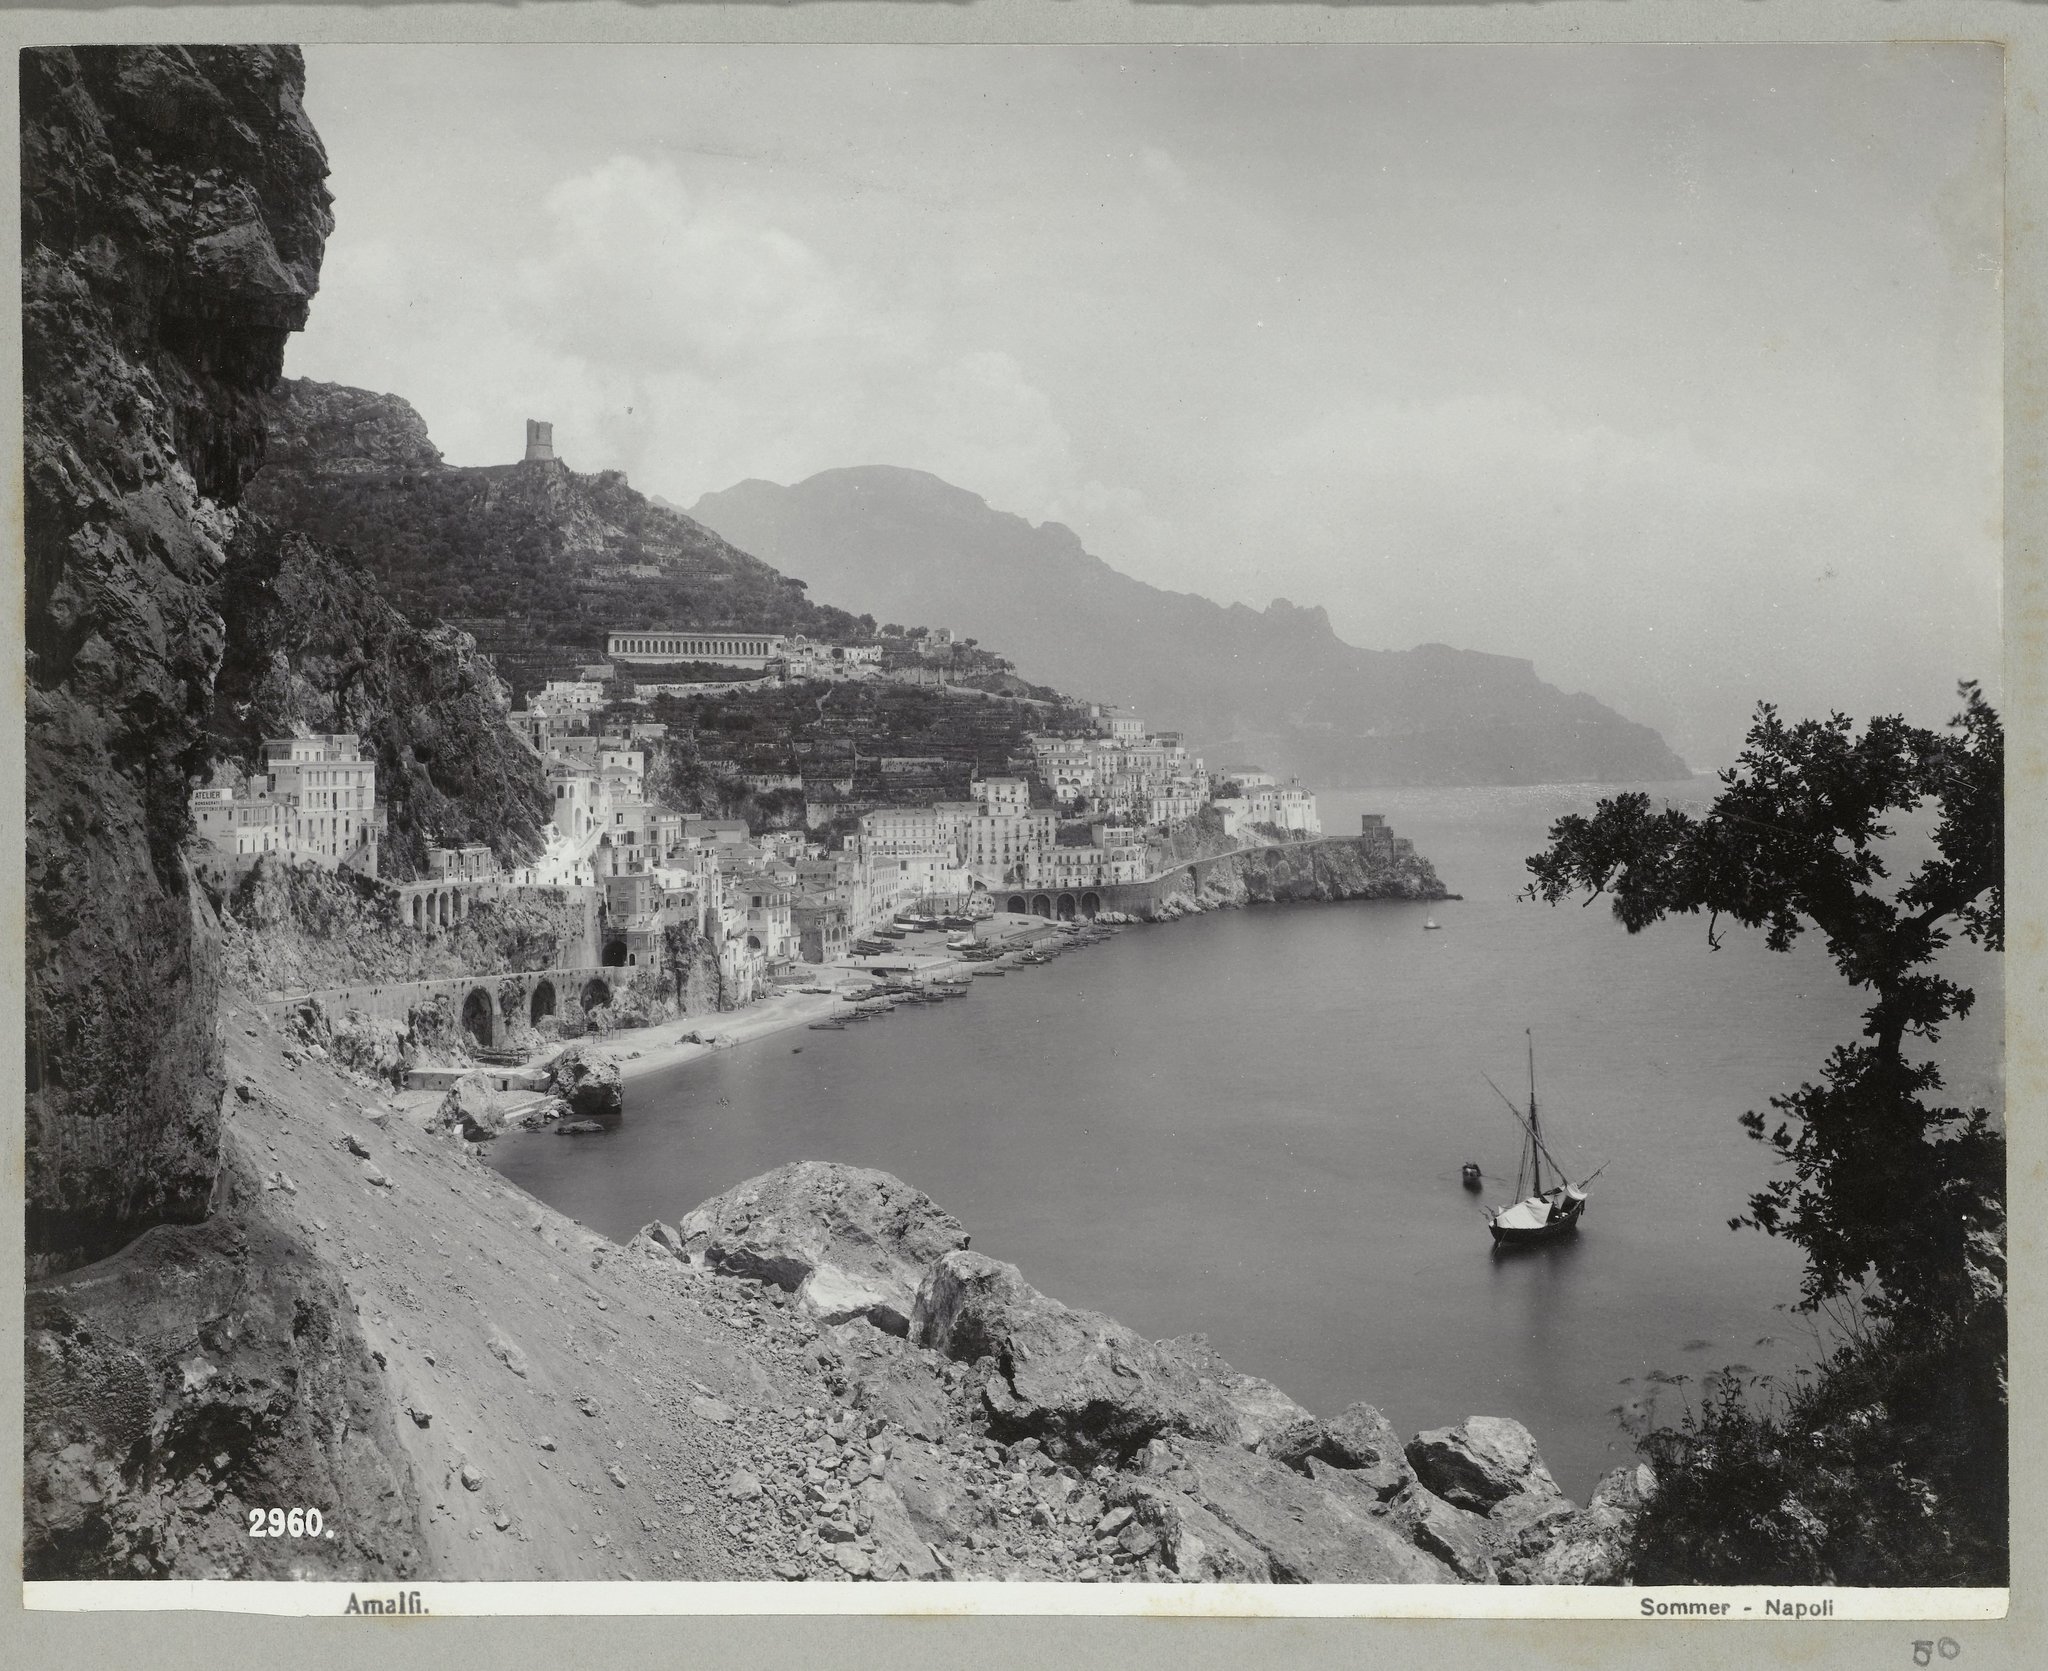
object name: photograph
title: 2960 Amalfi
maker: giorgio sommer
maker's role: fotograaf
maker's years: 1834-1914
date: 1888-1903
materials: cardboard, photographic support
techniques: albumen print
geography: netherlands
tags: amalfi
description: Panorama gezicht over de stad Amalfi gelegen aan de kust.